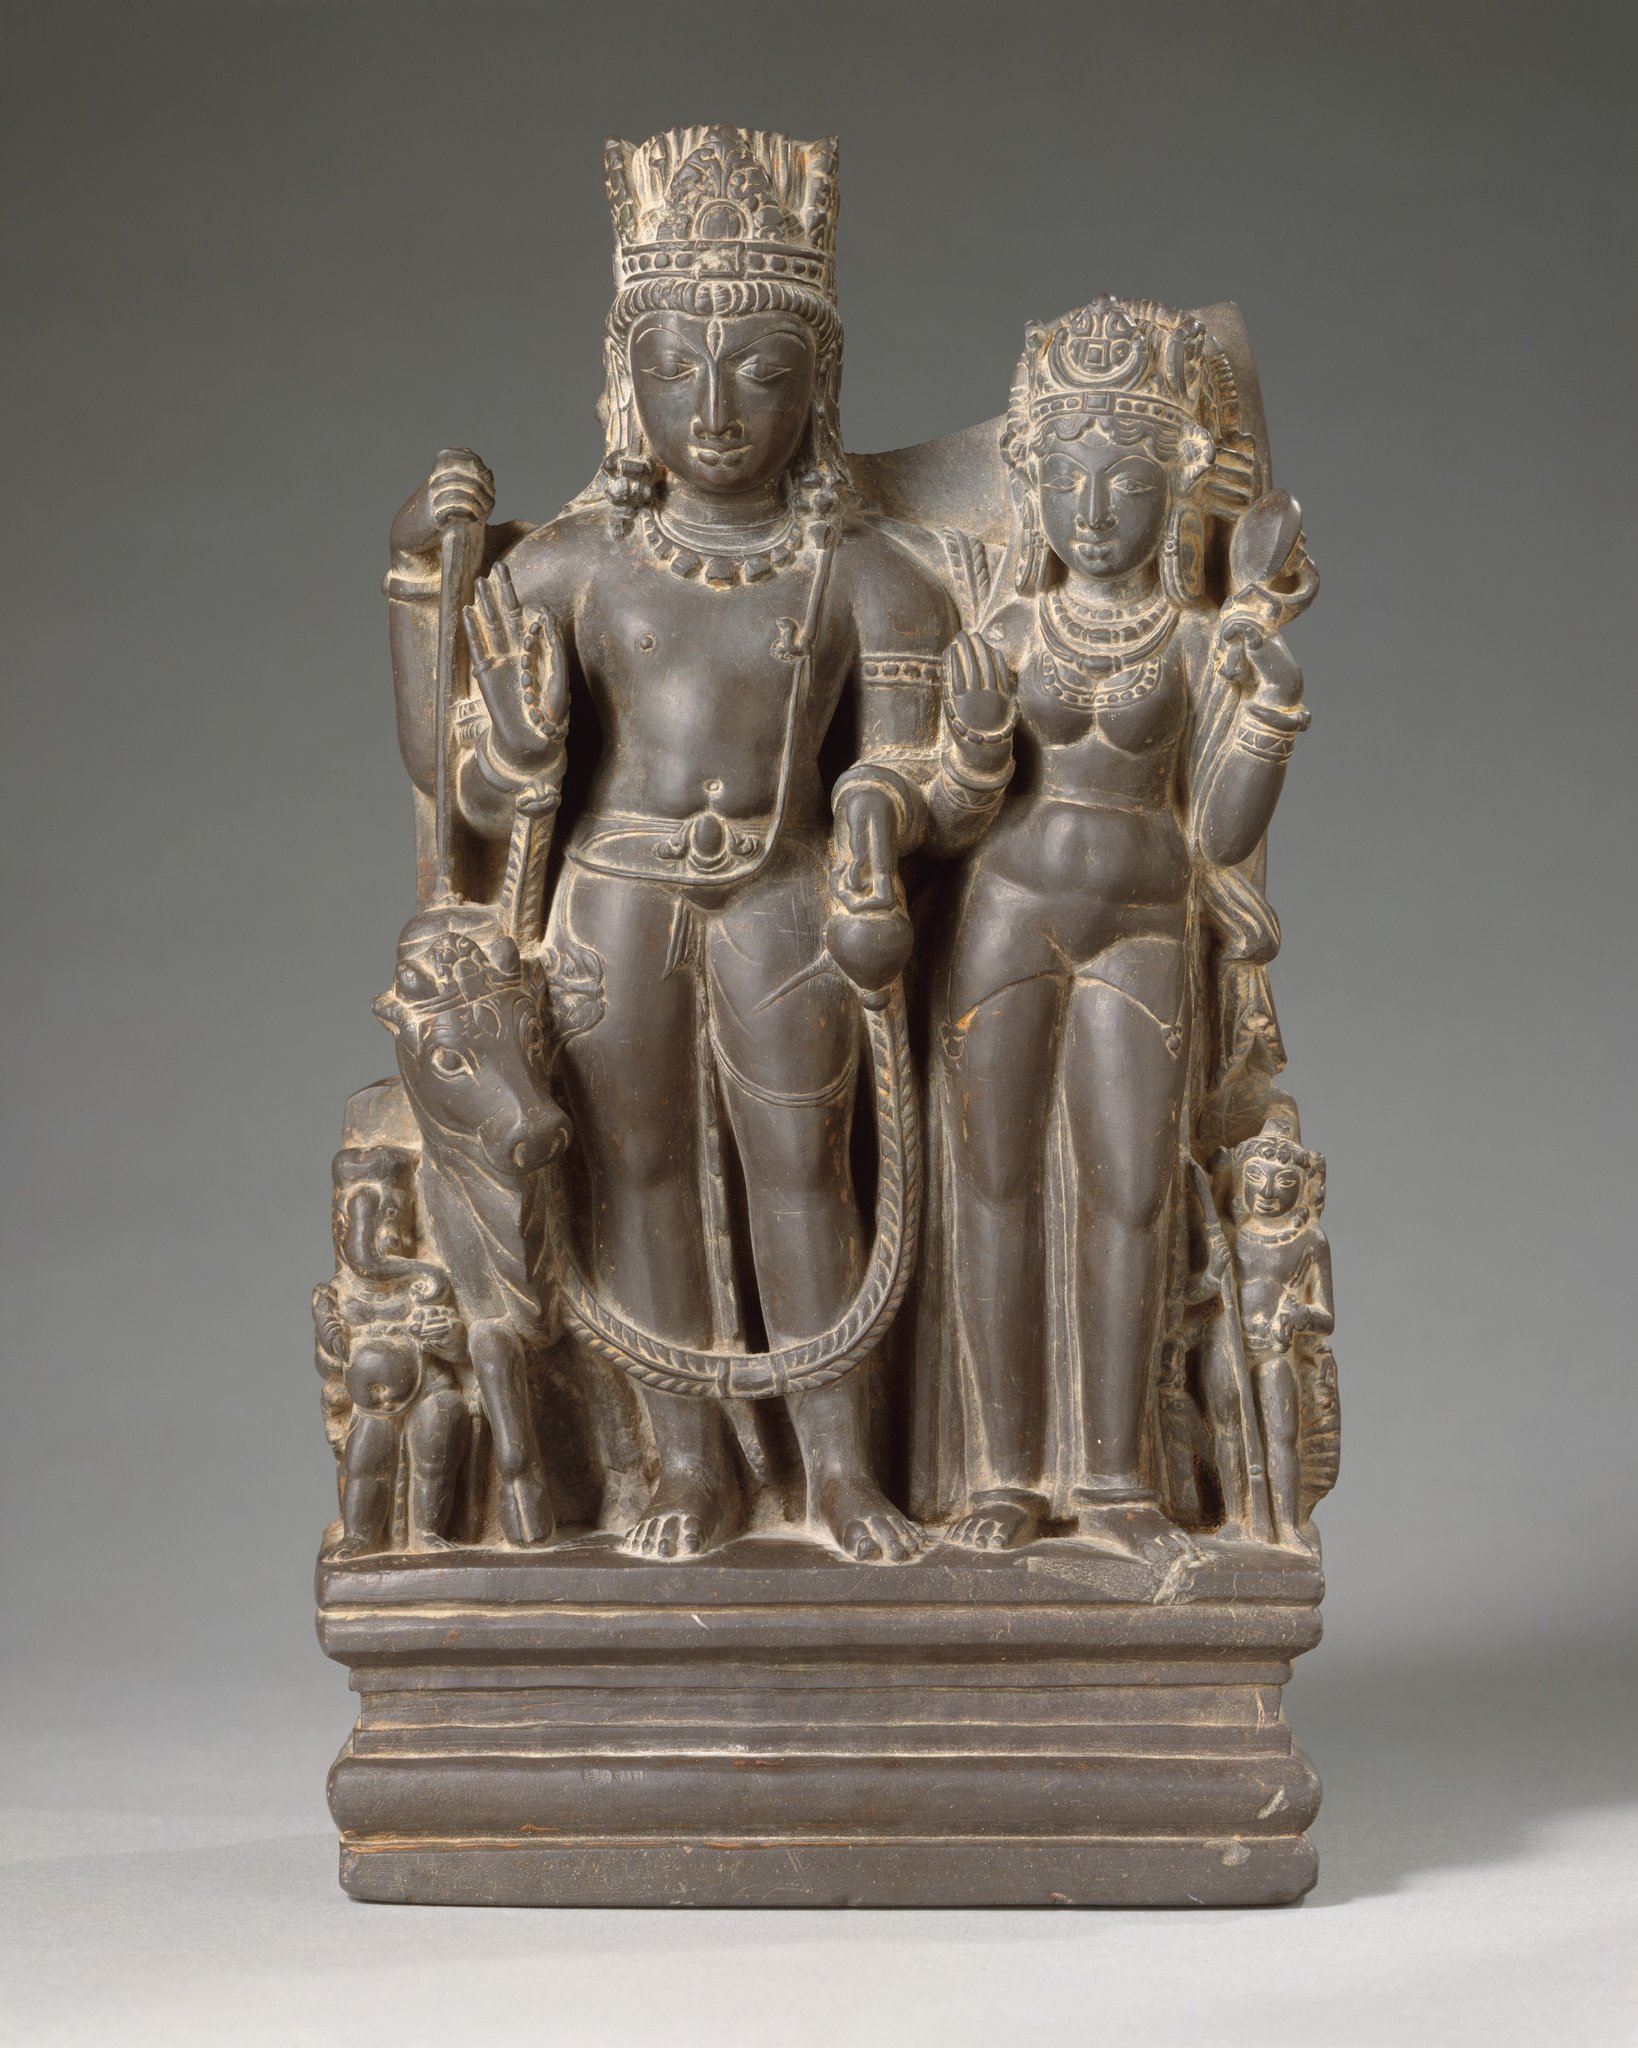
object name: figure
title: Shiva and Parvati with their Sons Karttikeya and Ganesha and the Calf Bull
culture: kashmiri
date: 801-900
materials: stone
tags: kashmir,bulls,ganesha,parvati,shiva,hinduism